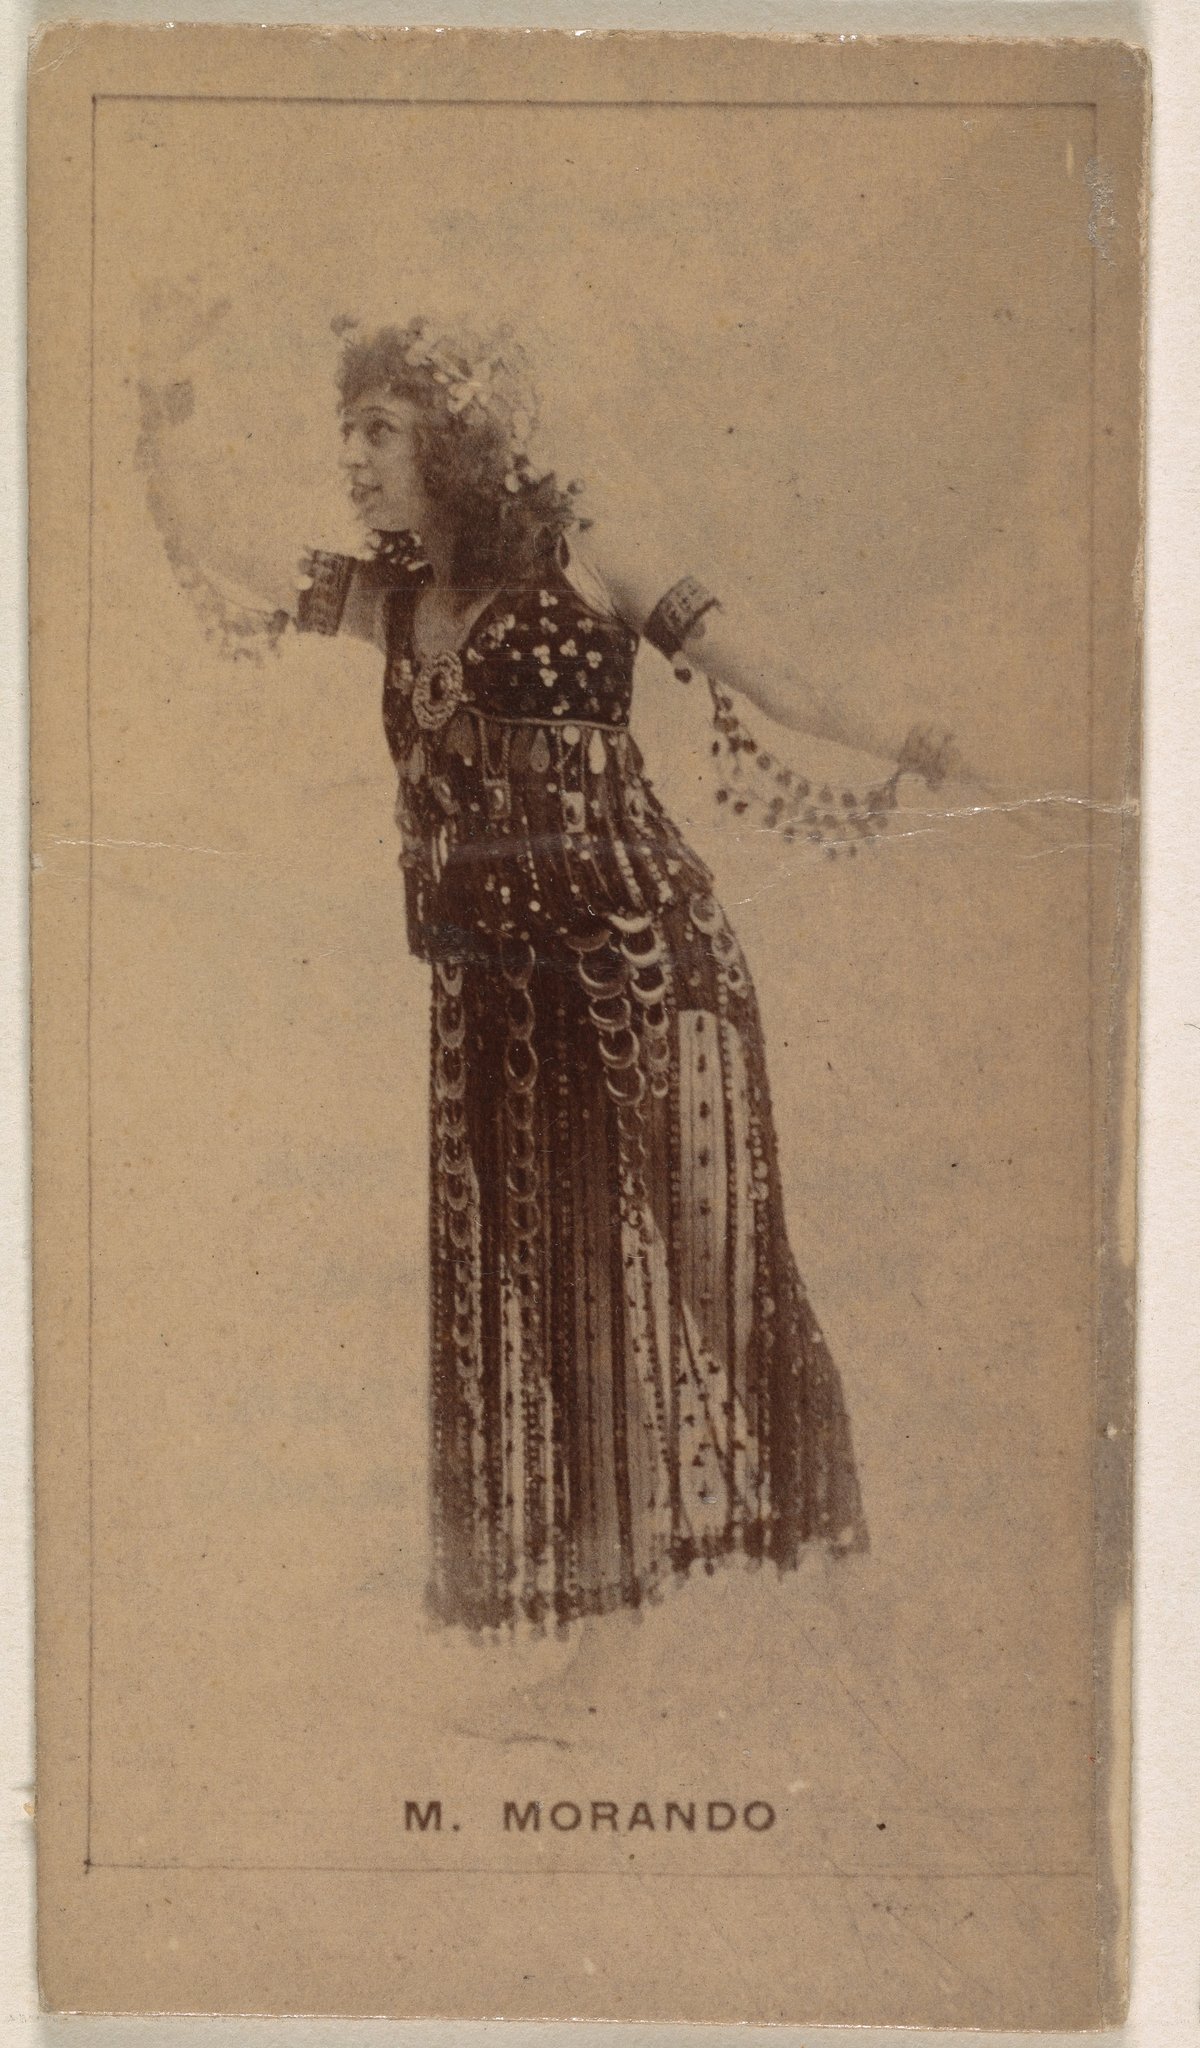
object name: photograph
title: M. Morando, from the Actresses series (N245) issued by Kinney Brothers to promote Sweet Caporal Cigarettes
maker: kinney brothers tobacco company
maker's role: publisher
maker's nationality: american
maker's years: 1869-2011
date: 1890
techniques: albumen silver print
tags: portraits,women,actresses